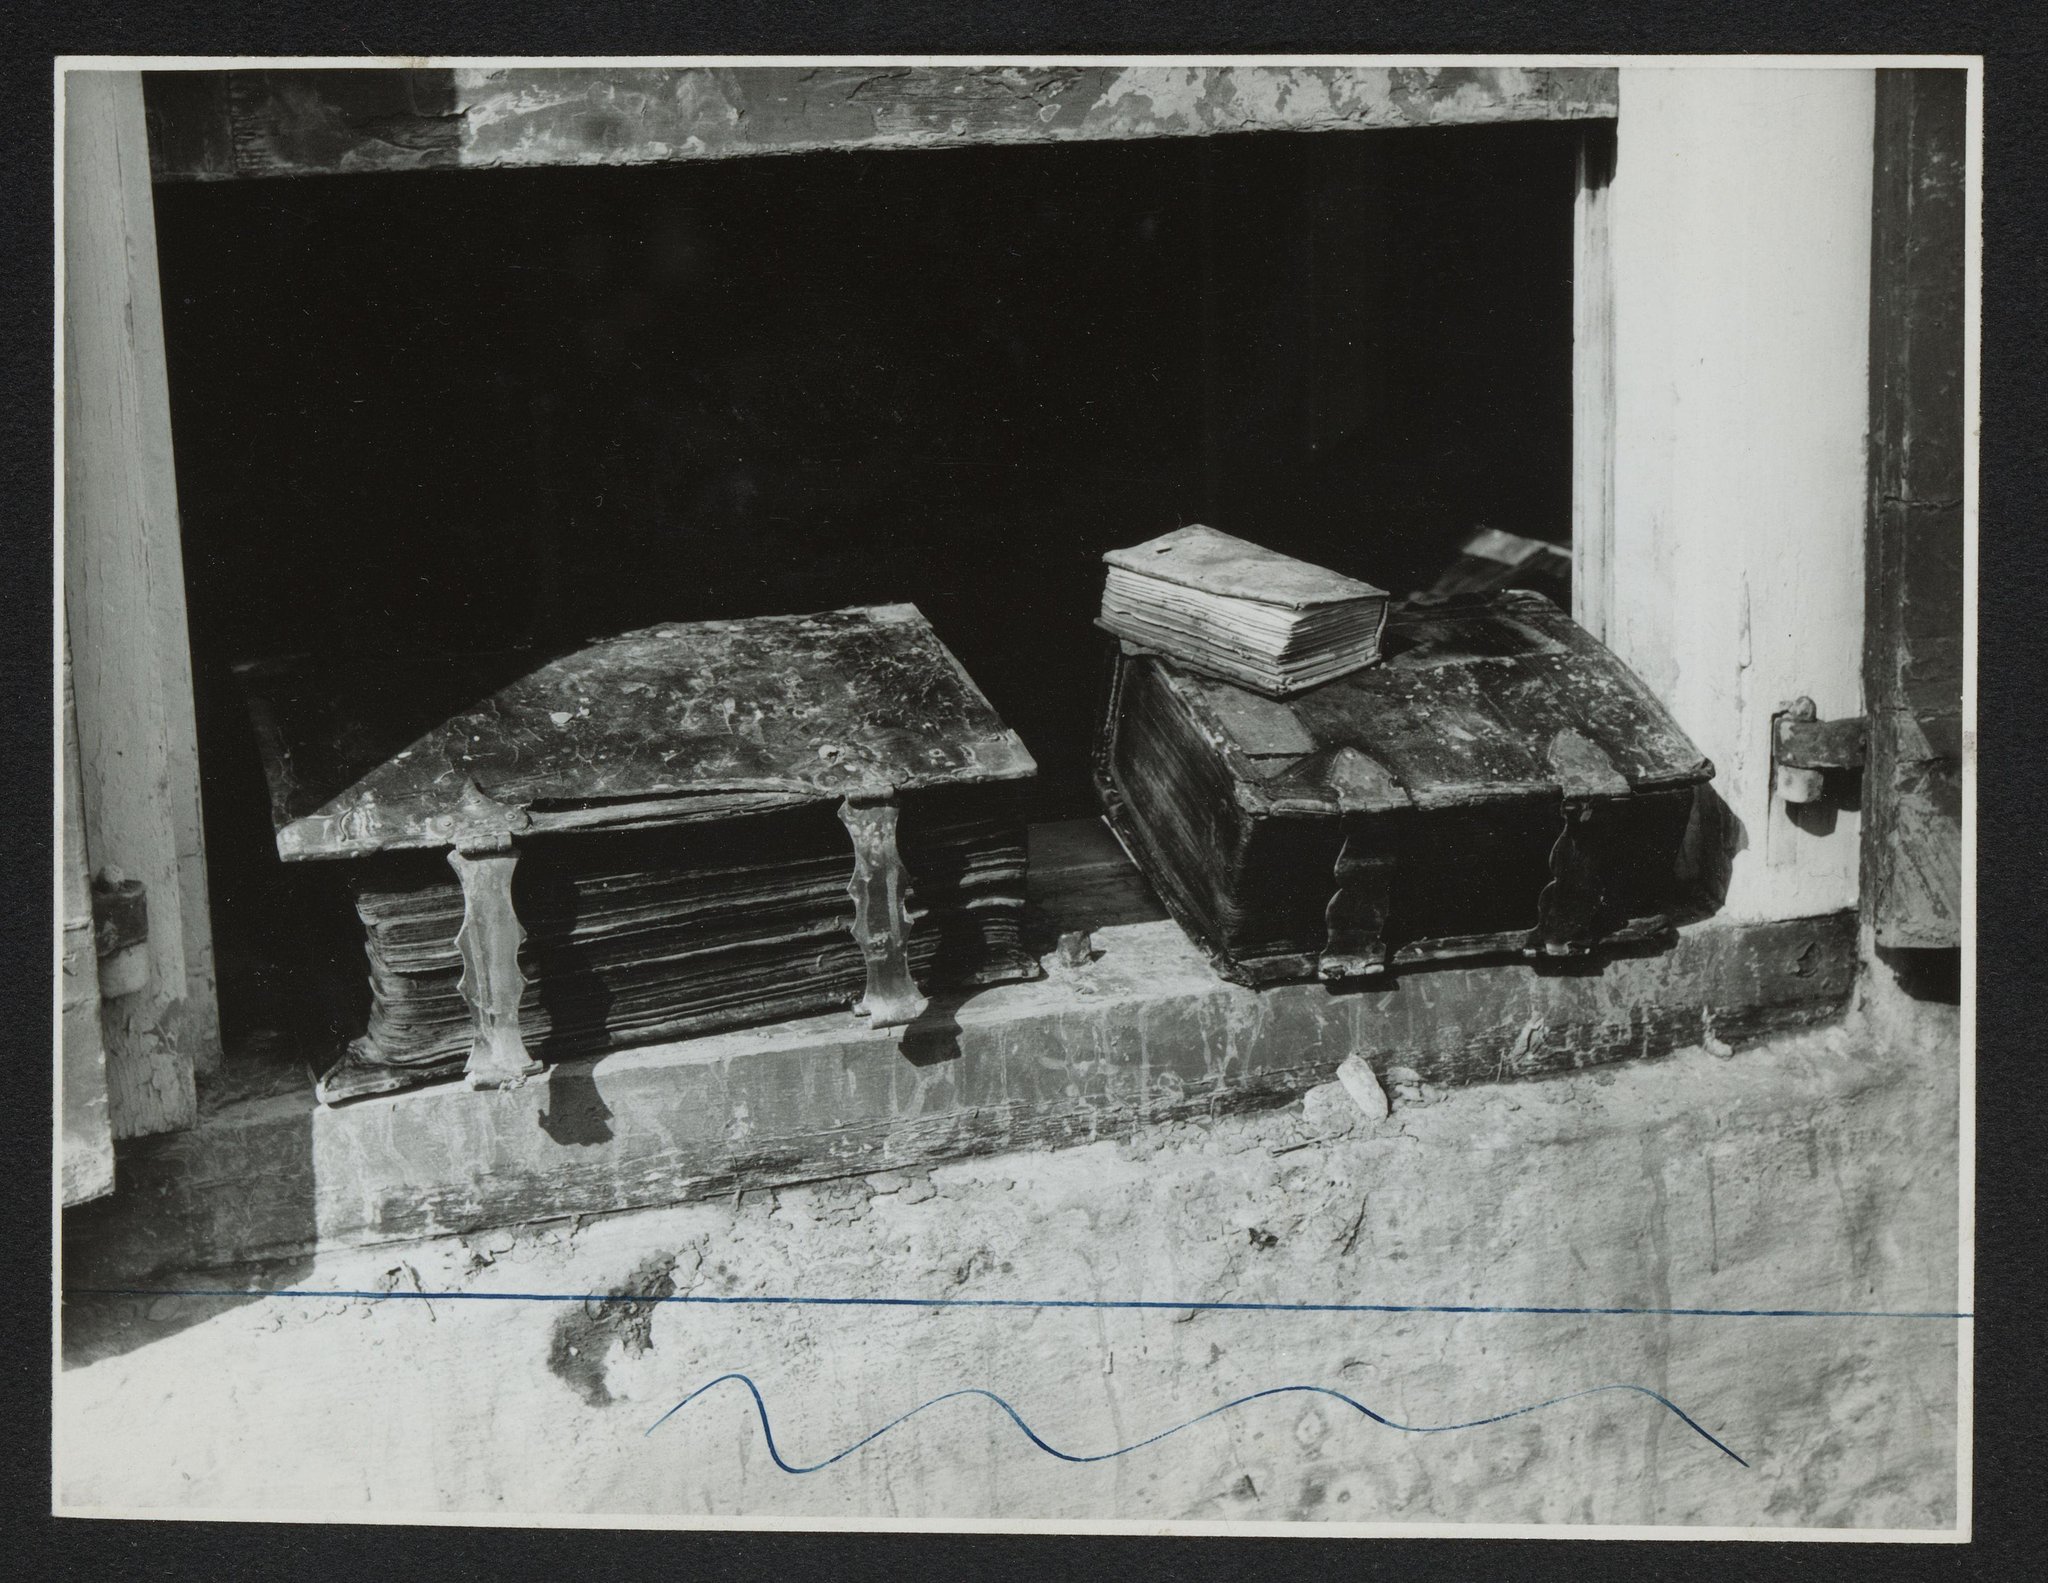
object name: photograph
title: Waterschade aan twee bijbels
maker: Anonymous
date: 1902-1953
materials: photographic support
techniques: gelatin silver print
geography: zeeland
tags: the bible as a book, north sea flood of 1953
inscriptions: copyright notice: ‘Copyright I.P.O. International Photopress Office’, label: ‘Weinig of niets konden de bewoners ... herinnering tevens aan het voorgeslacht.’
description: Twee Statenbijbels en een psalmboek liggen in een raamkozijn in de zon te drogen na in het water te zijn gekomen tijdens de watersnoodramp, Sint-Philipsland, begin februari 1953.